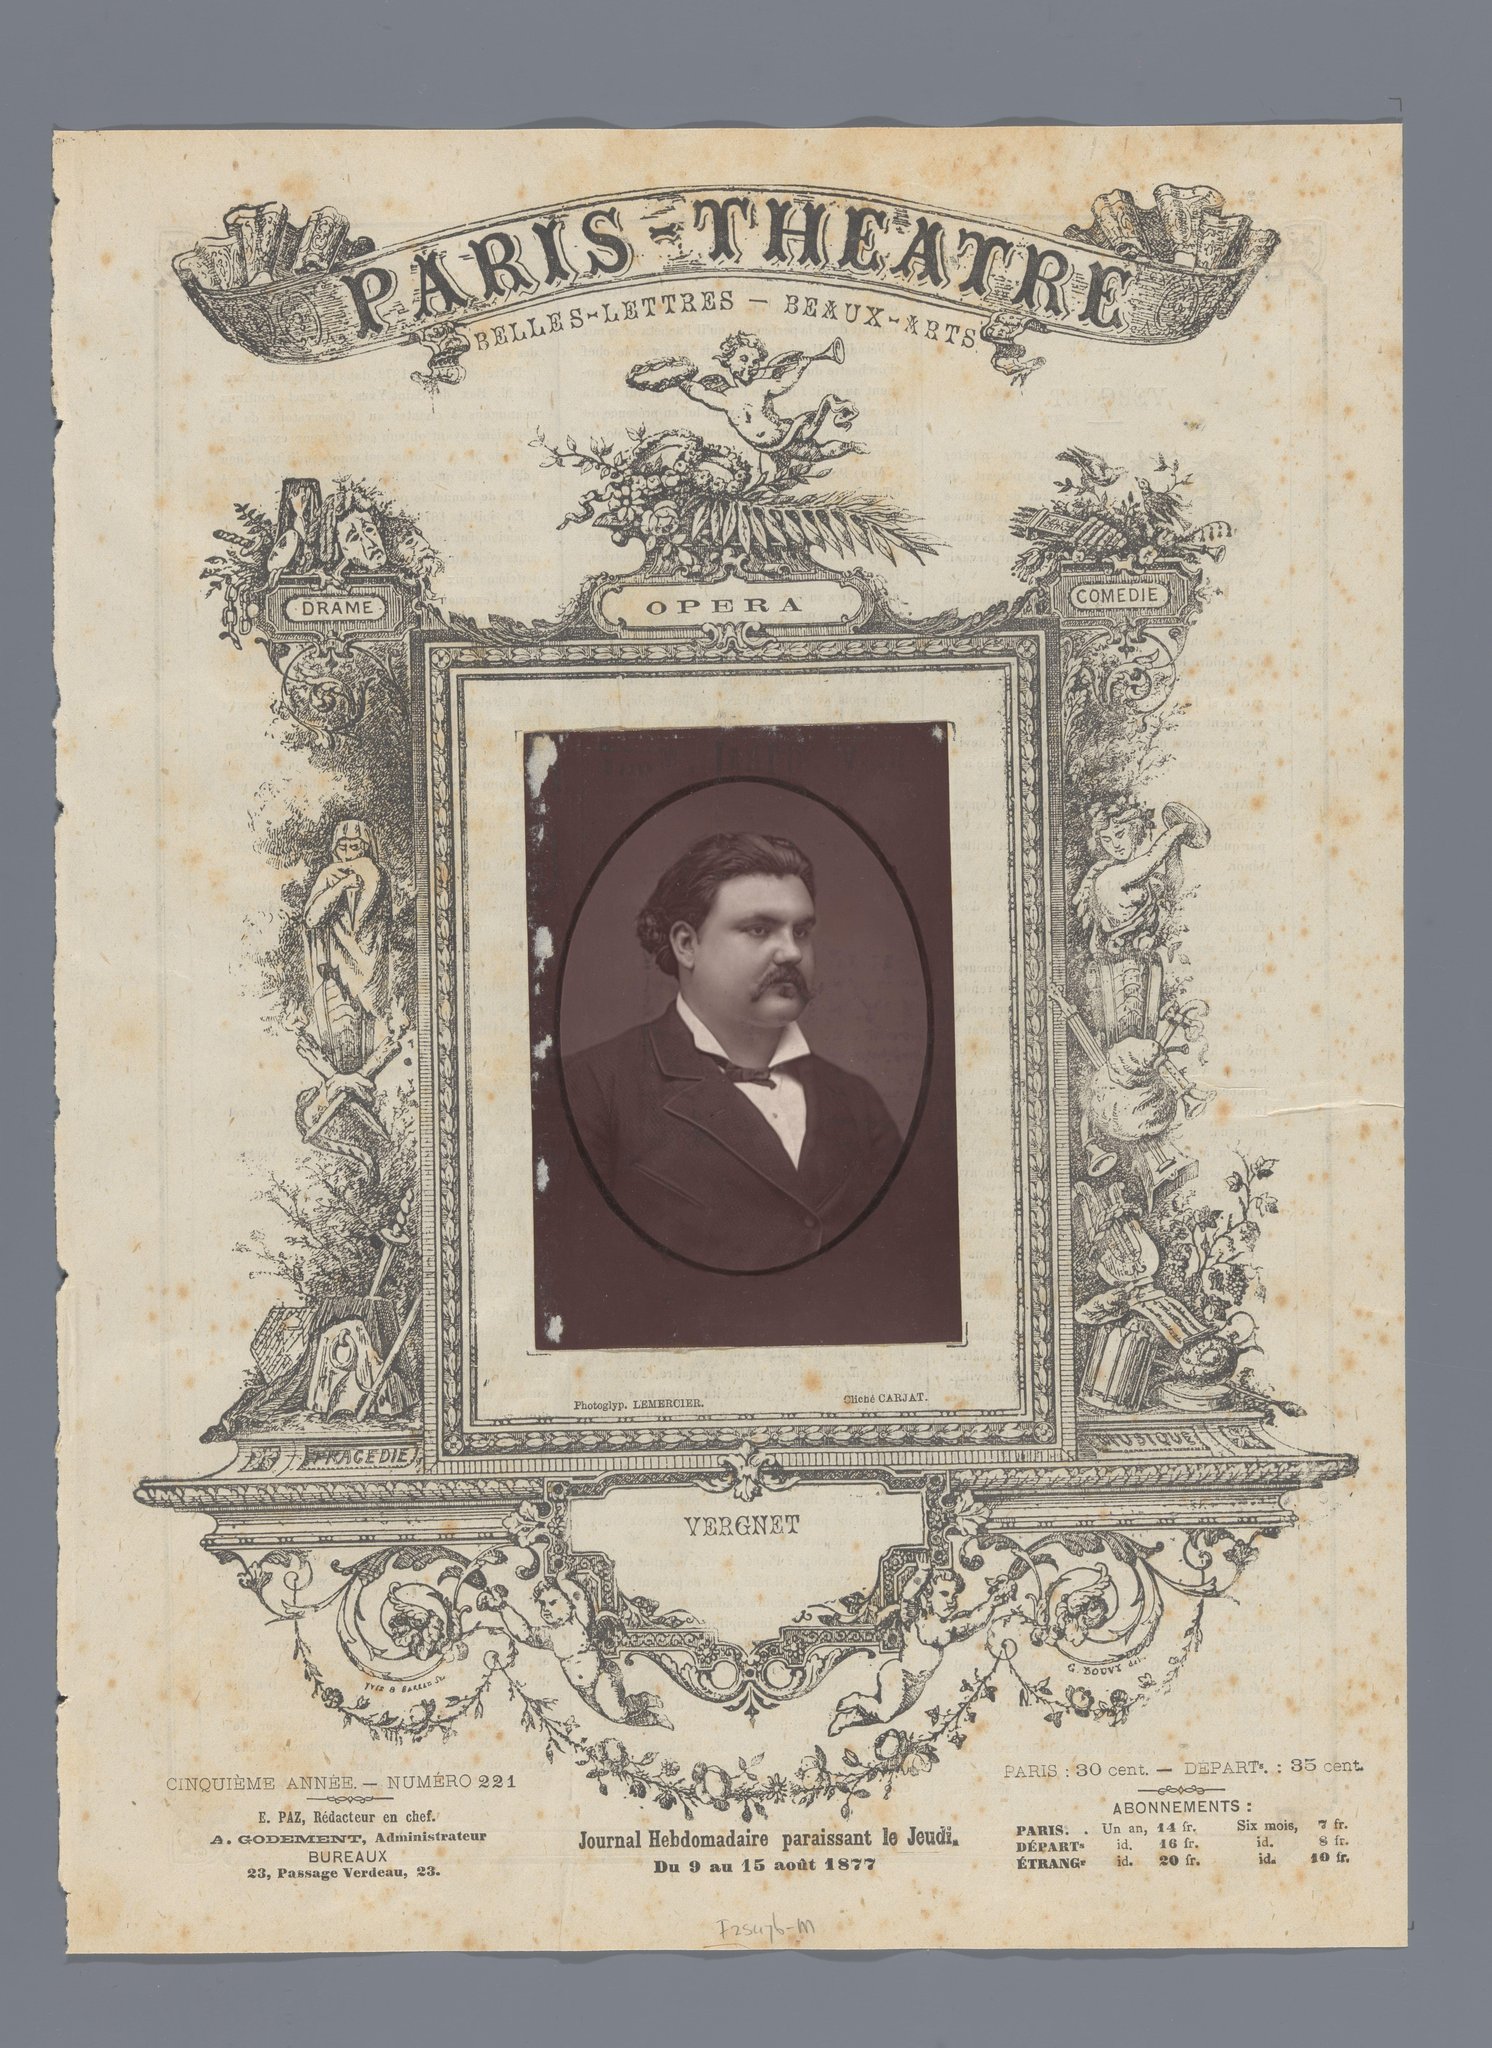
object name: photomechanical print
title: Portret van Edmond Vergnet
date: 1872-1879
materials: paper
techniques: woodburytype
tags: historical persons